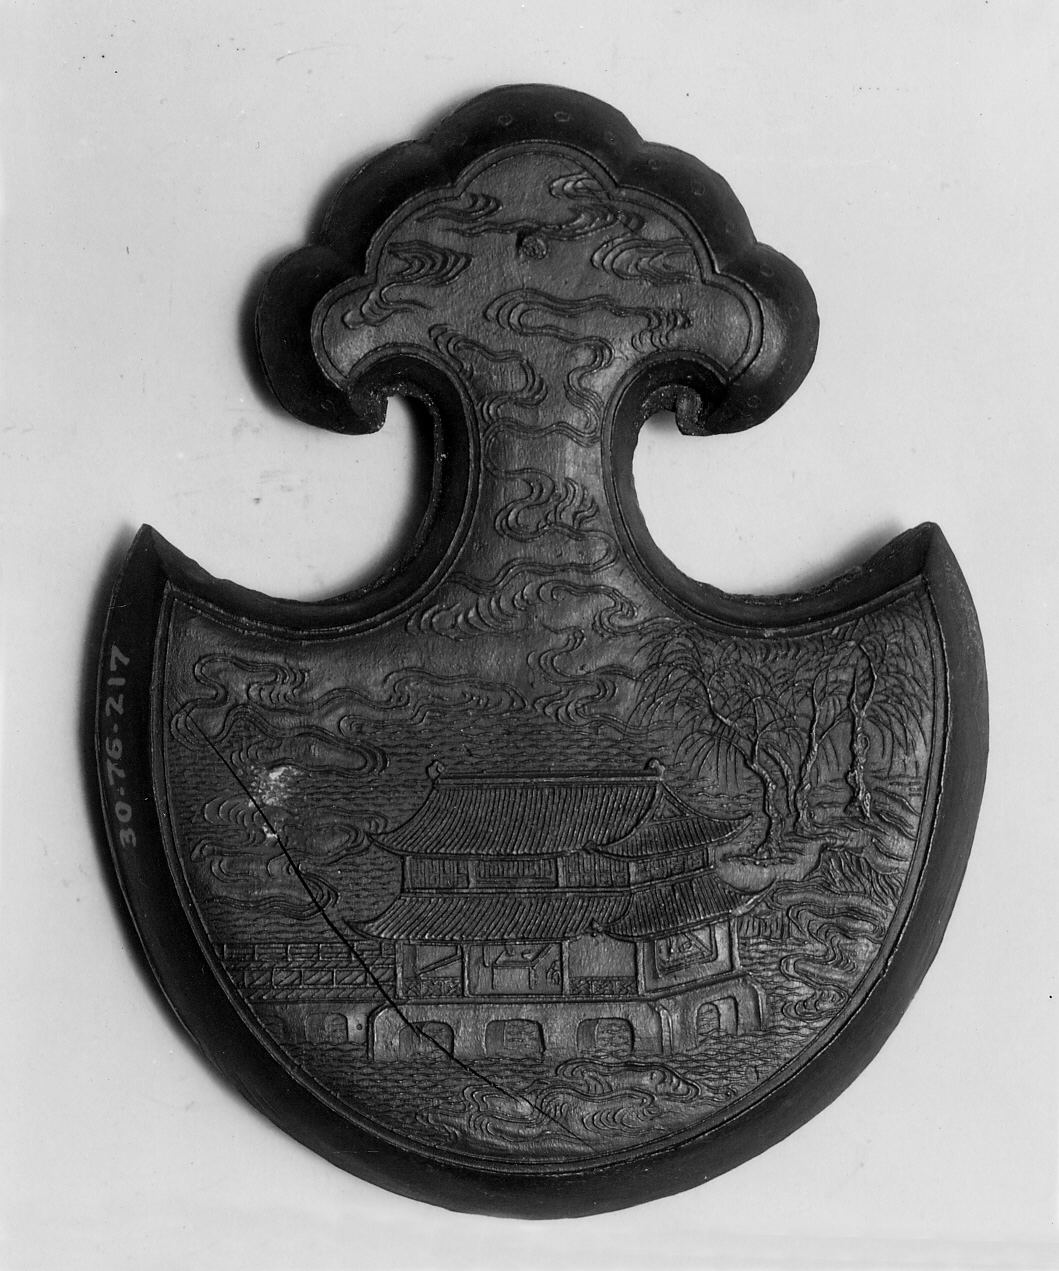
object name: ink tablet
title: Ink Pond Clouds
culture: chinese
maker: jian guzhai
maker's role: artist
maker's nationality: chinese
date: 1867-1933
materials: gilt, wood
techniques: bookbinding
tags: buildings